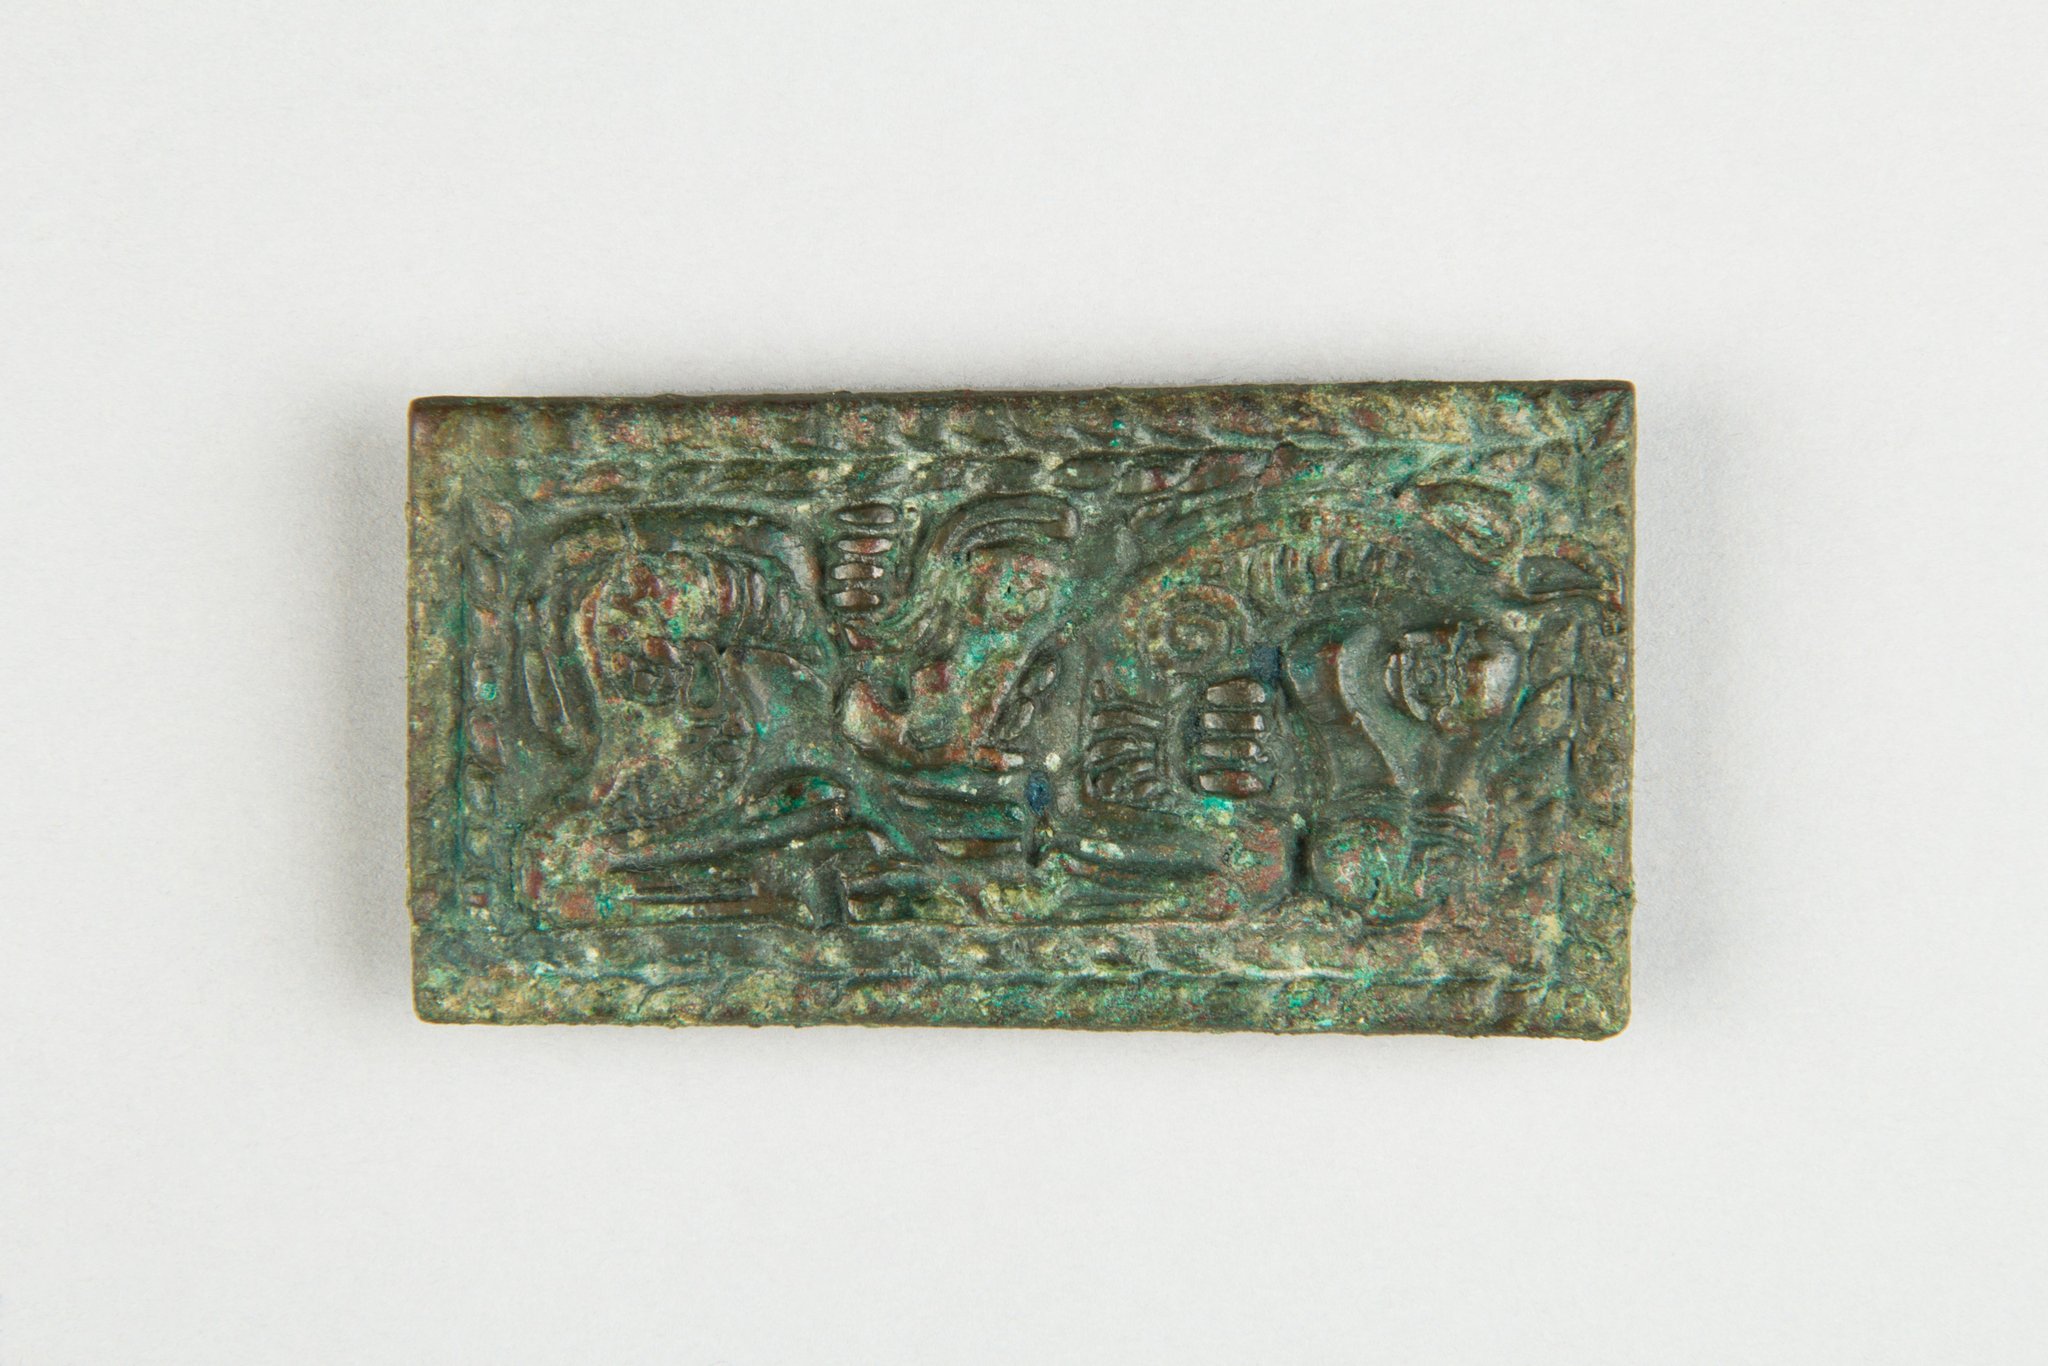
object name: belt plaque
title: Belt Plaque with Horse and Wolf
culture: north chinese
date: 300-101 BCE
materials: bronze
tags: horses